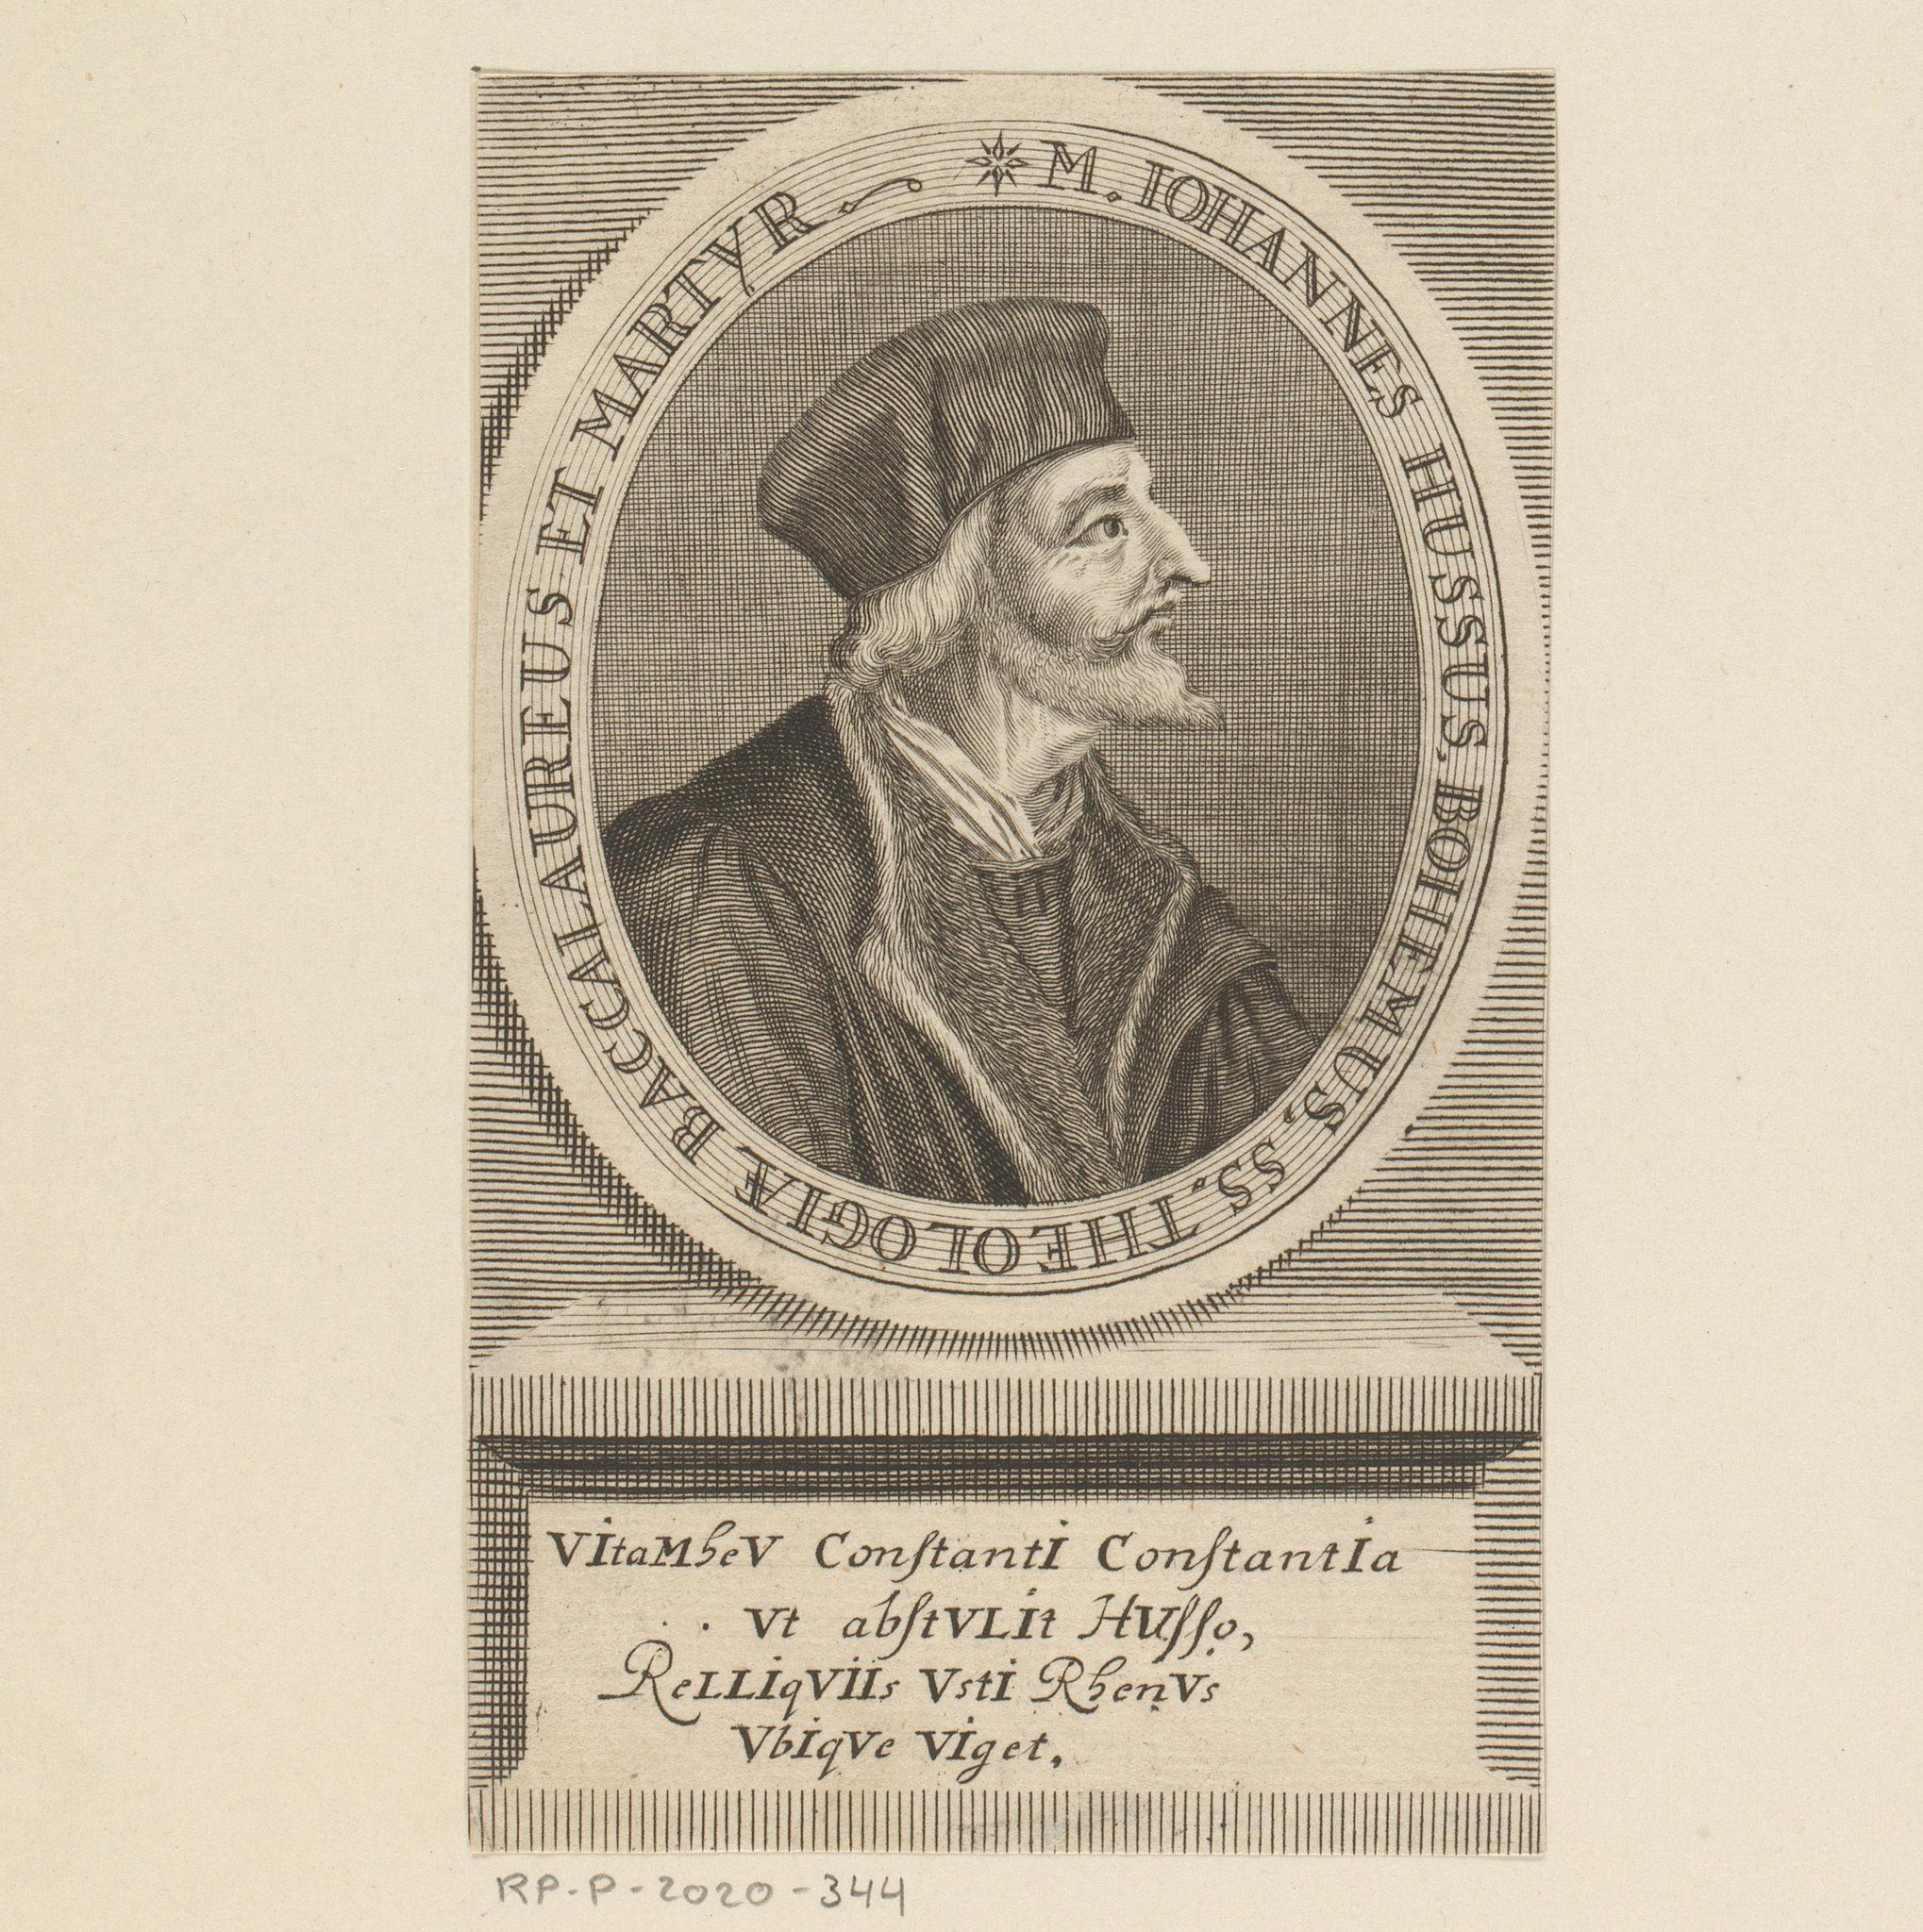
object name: print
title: Portret van Johannes Hus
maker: Anonymous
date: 1700-1749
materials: paper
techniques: engraving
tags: theologian, historical persons